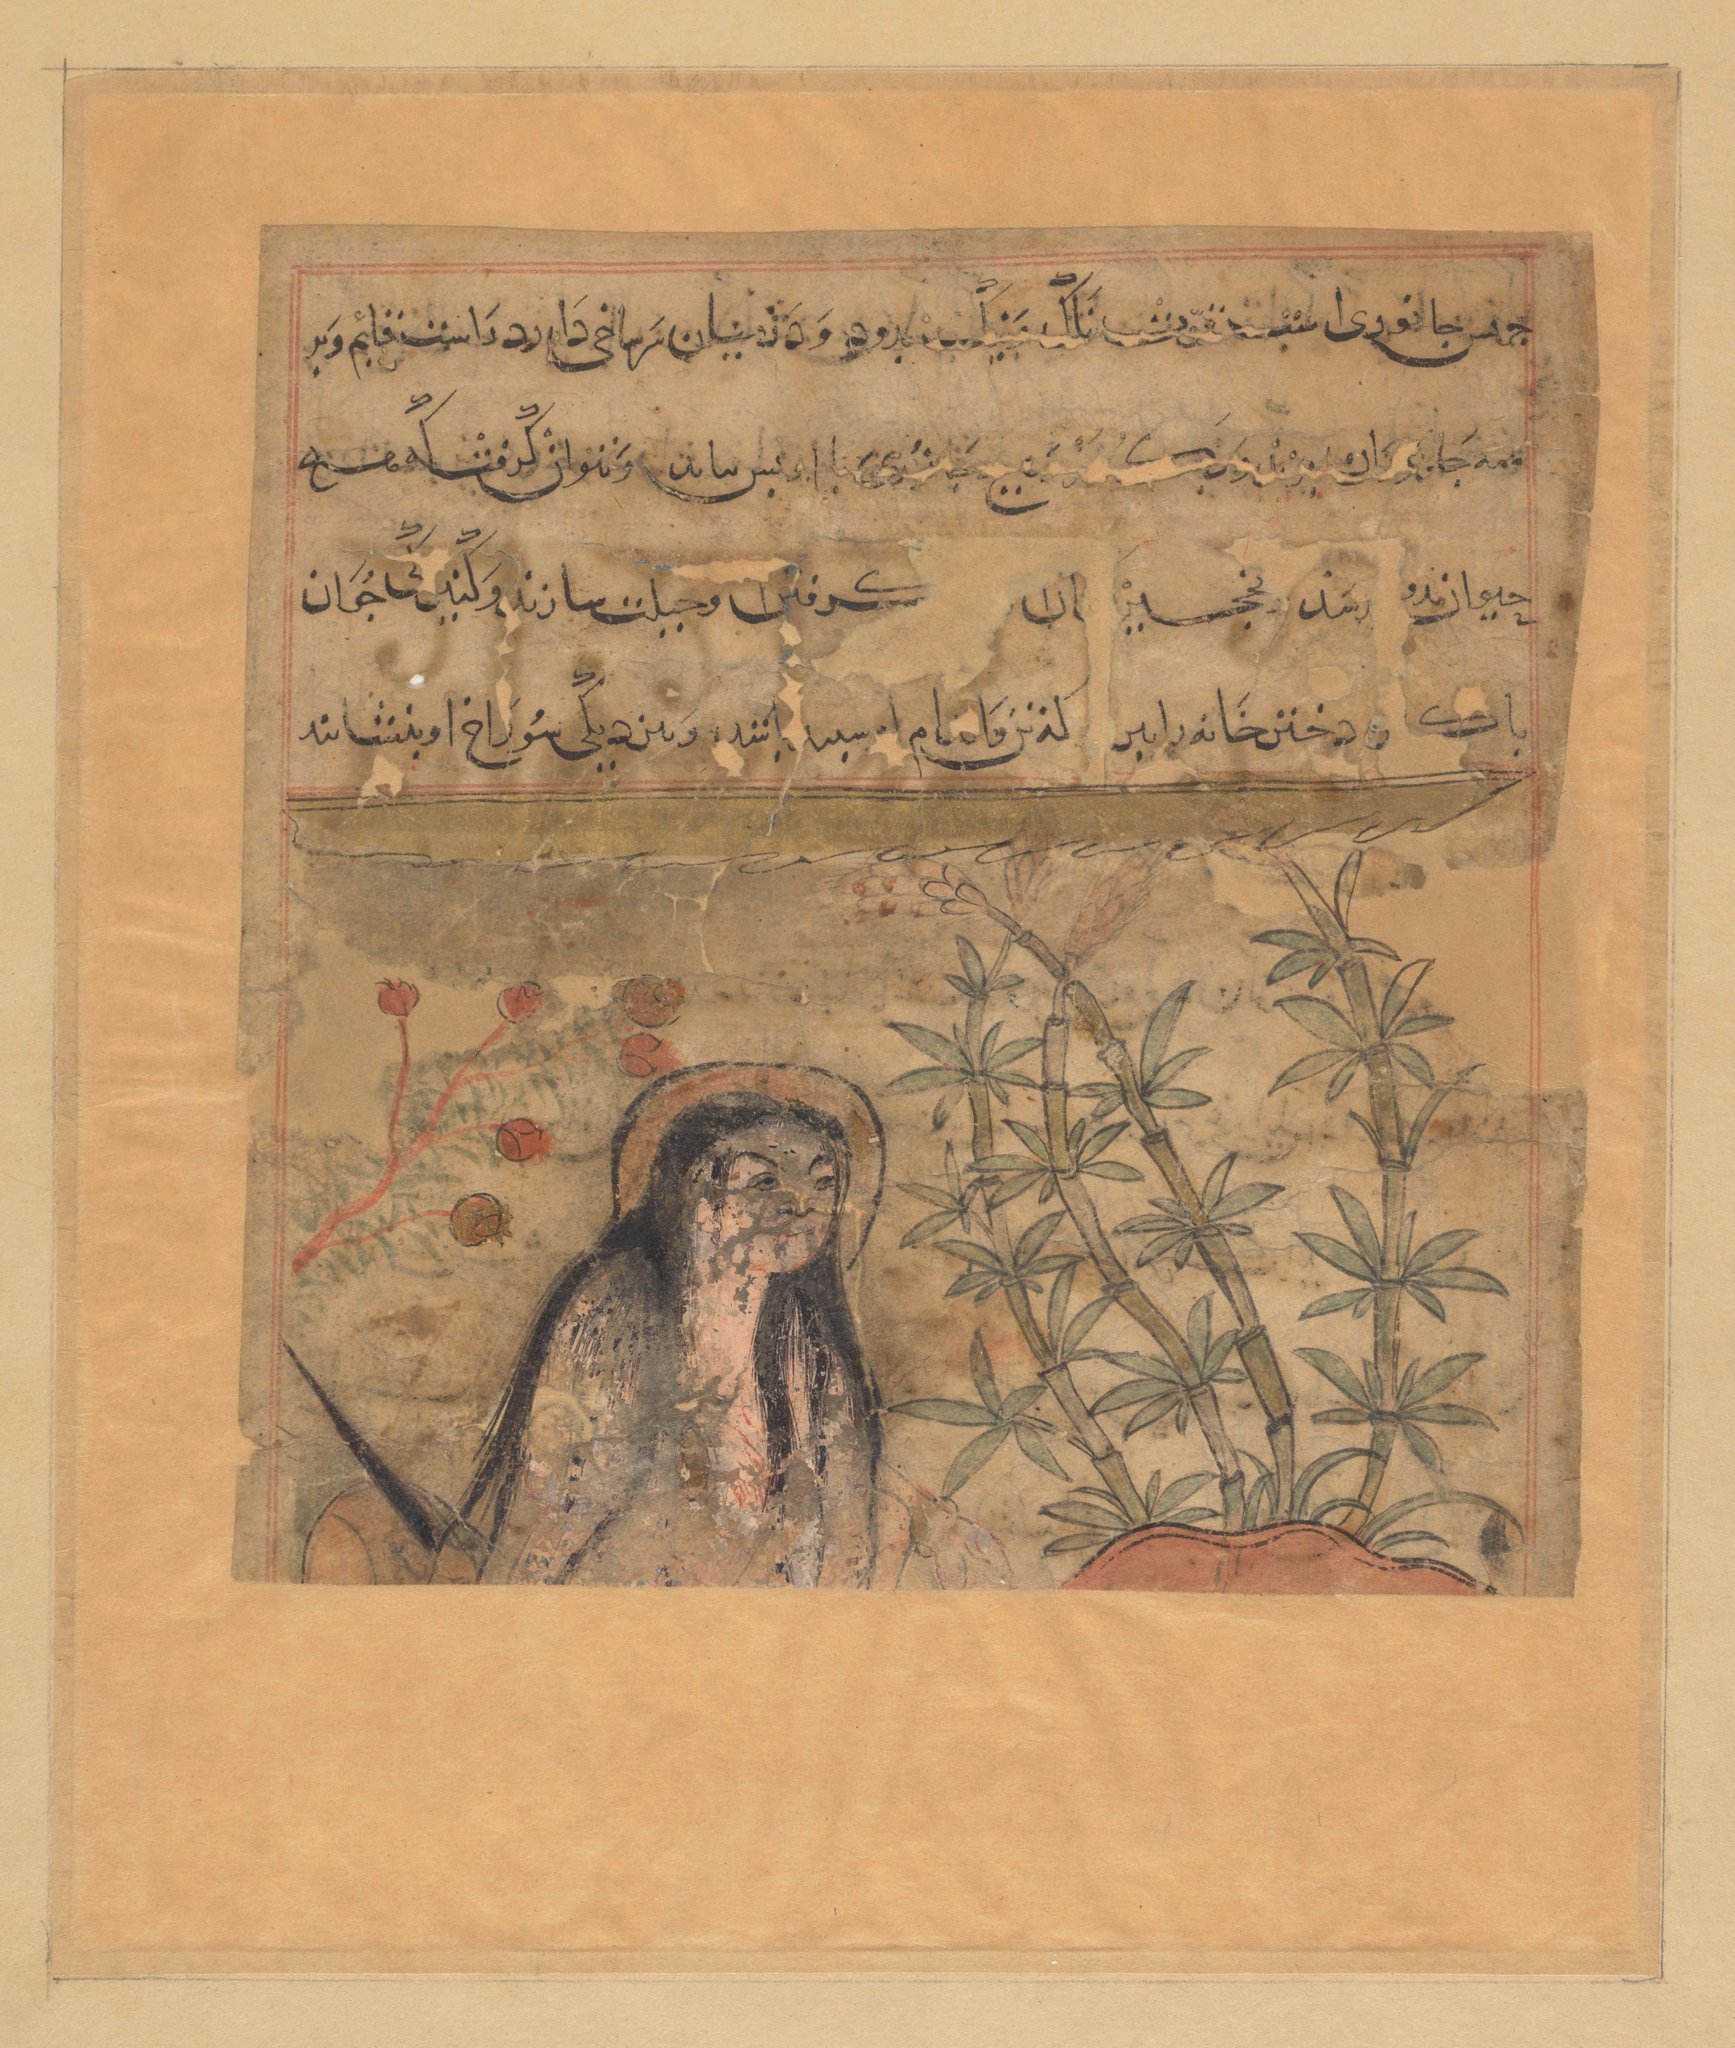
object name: persian miniature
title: Vrouw met bamboe en bloemen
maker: Anonymous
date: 1400-1500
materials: paper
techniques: brush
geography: iran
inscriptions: inscription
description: Een voorstelling van een verwilderd uitziende vrouw met bloemstruiken en bamboe, daarboven een blok met oud-Perzische tekst. Het blad is opgeplakt op een vergeeld blad en dat is weer op een wat minder verkleurd blad opgeplakt.